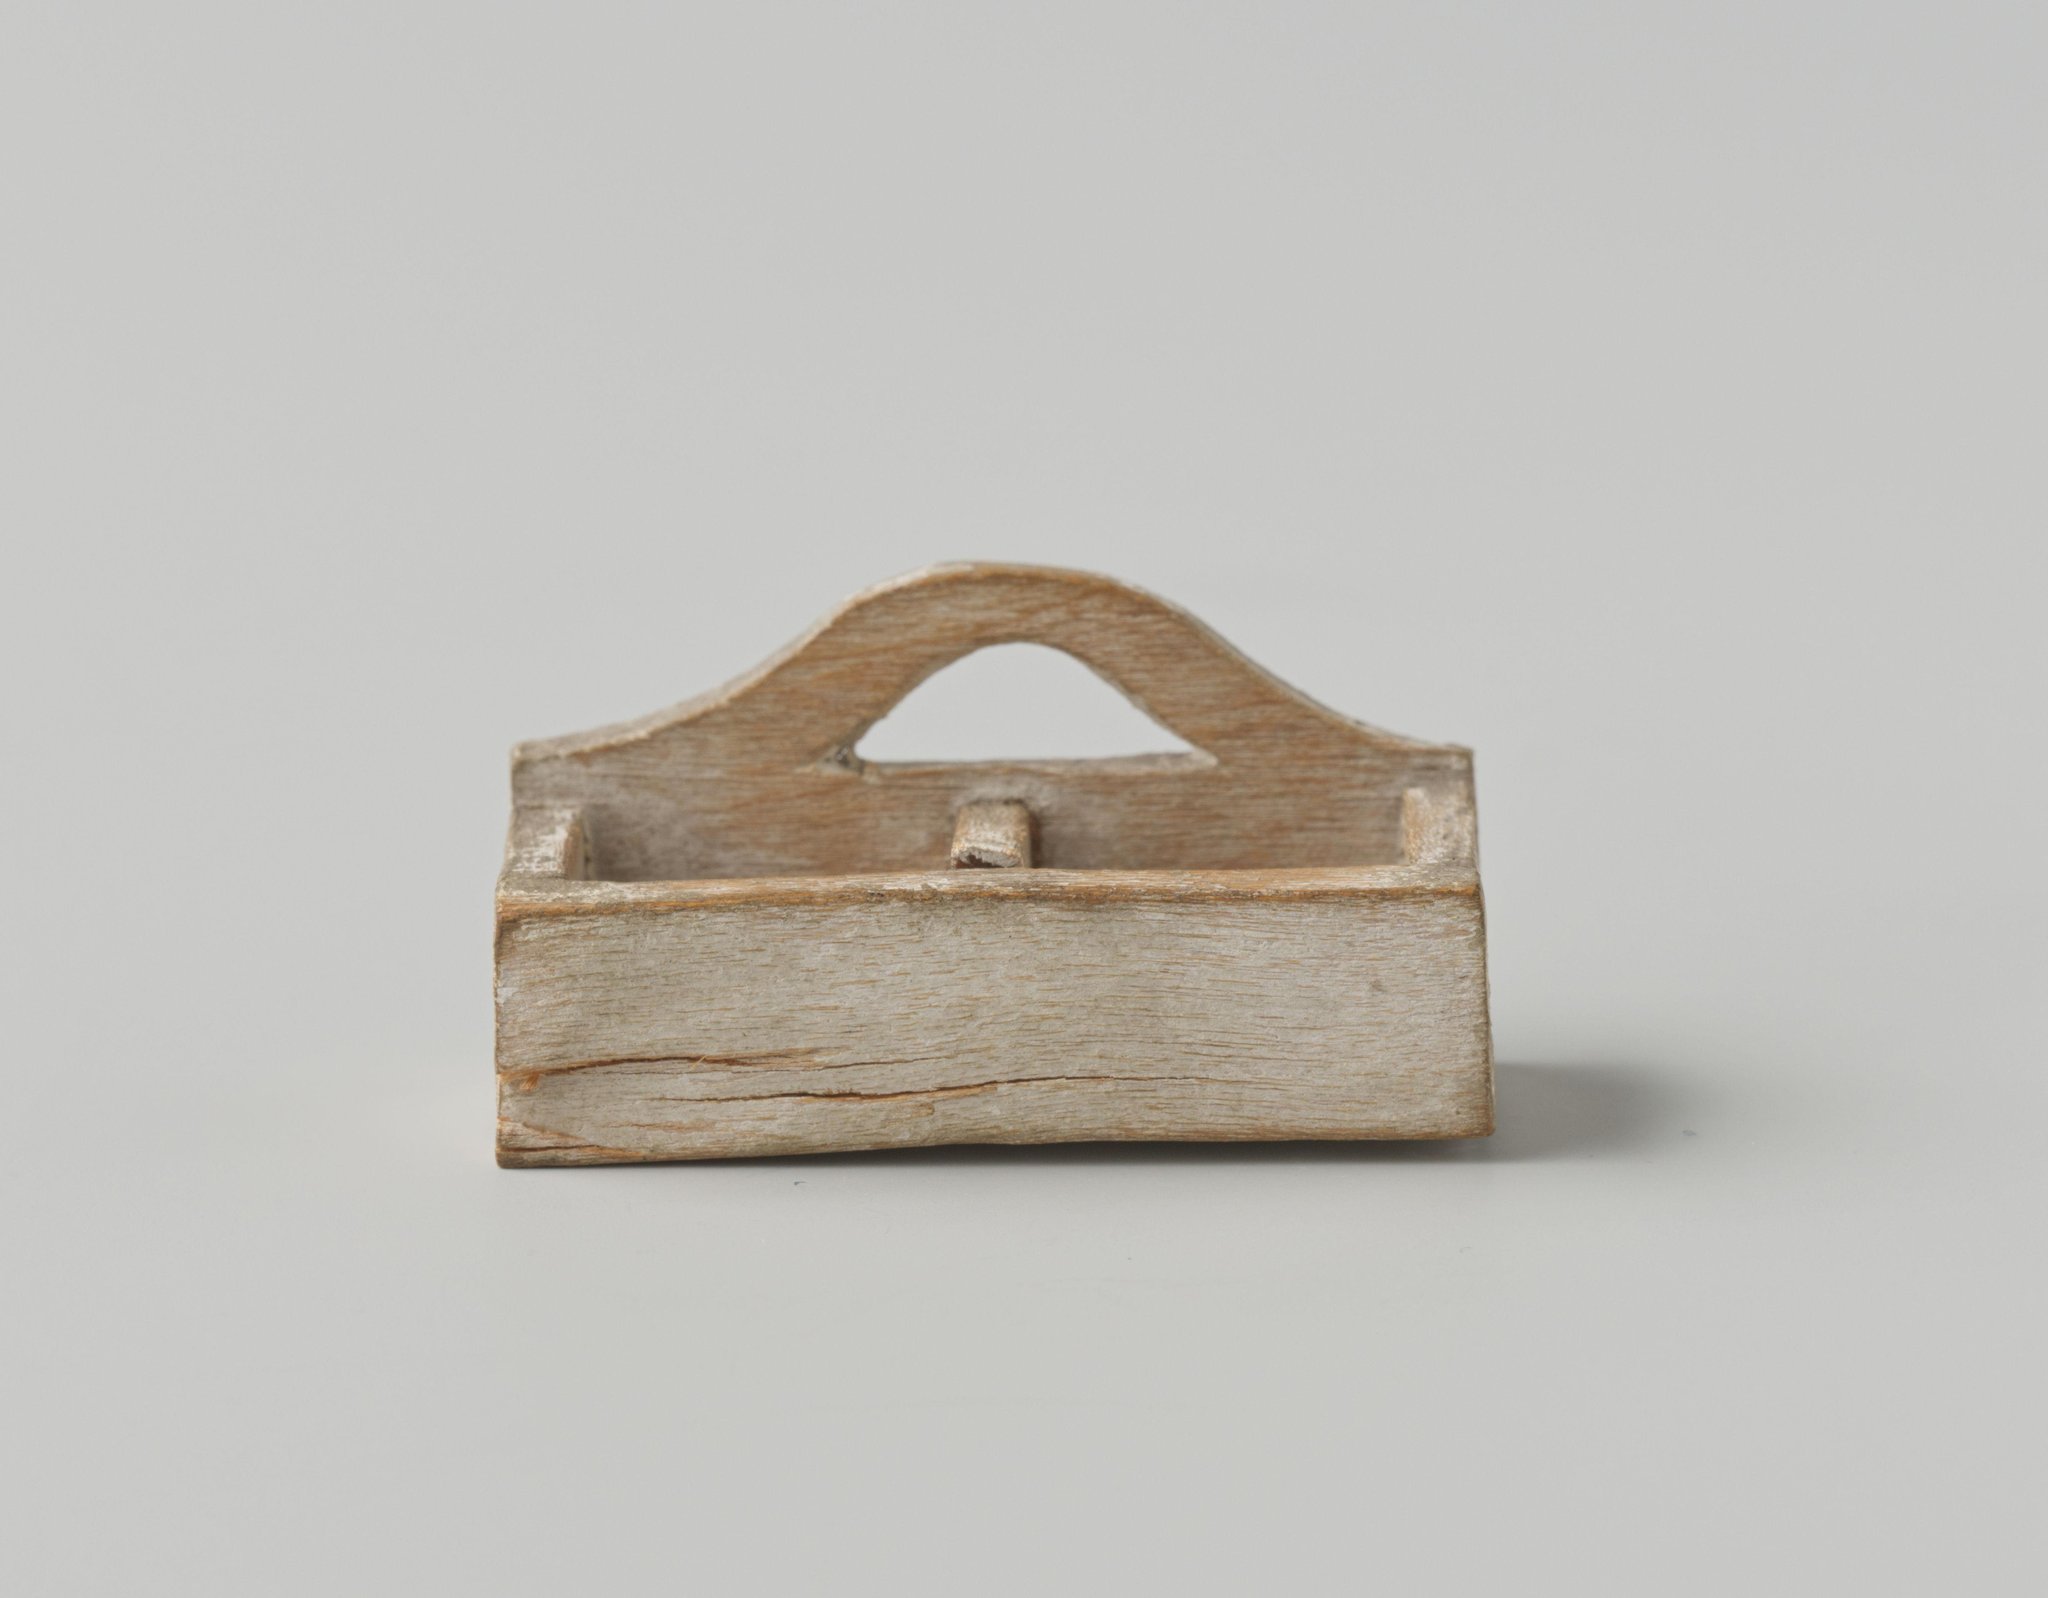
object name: miniature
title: Wandbakje van een wit gesausde withoutsoort, met verdeling in twee vakken voor zand en dergelijke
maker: Anonymous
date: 1690-1710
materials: wood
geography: amsterdam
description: Wandbakje van een wit gesausde withoutsoort, met verdeling in twee vakken voor zand en dergelijke.